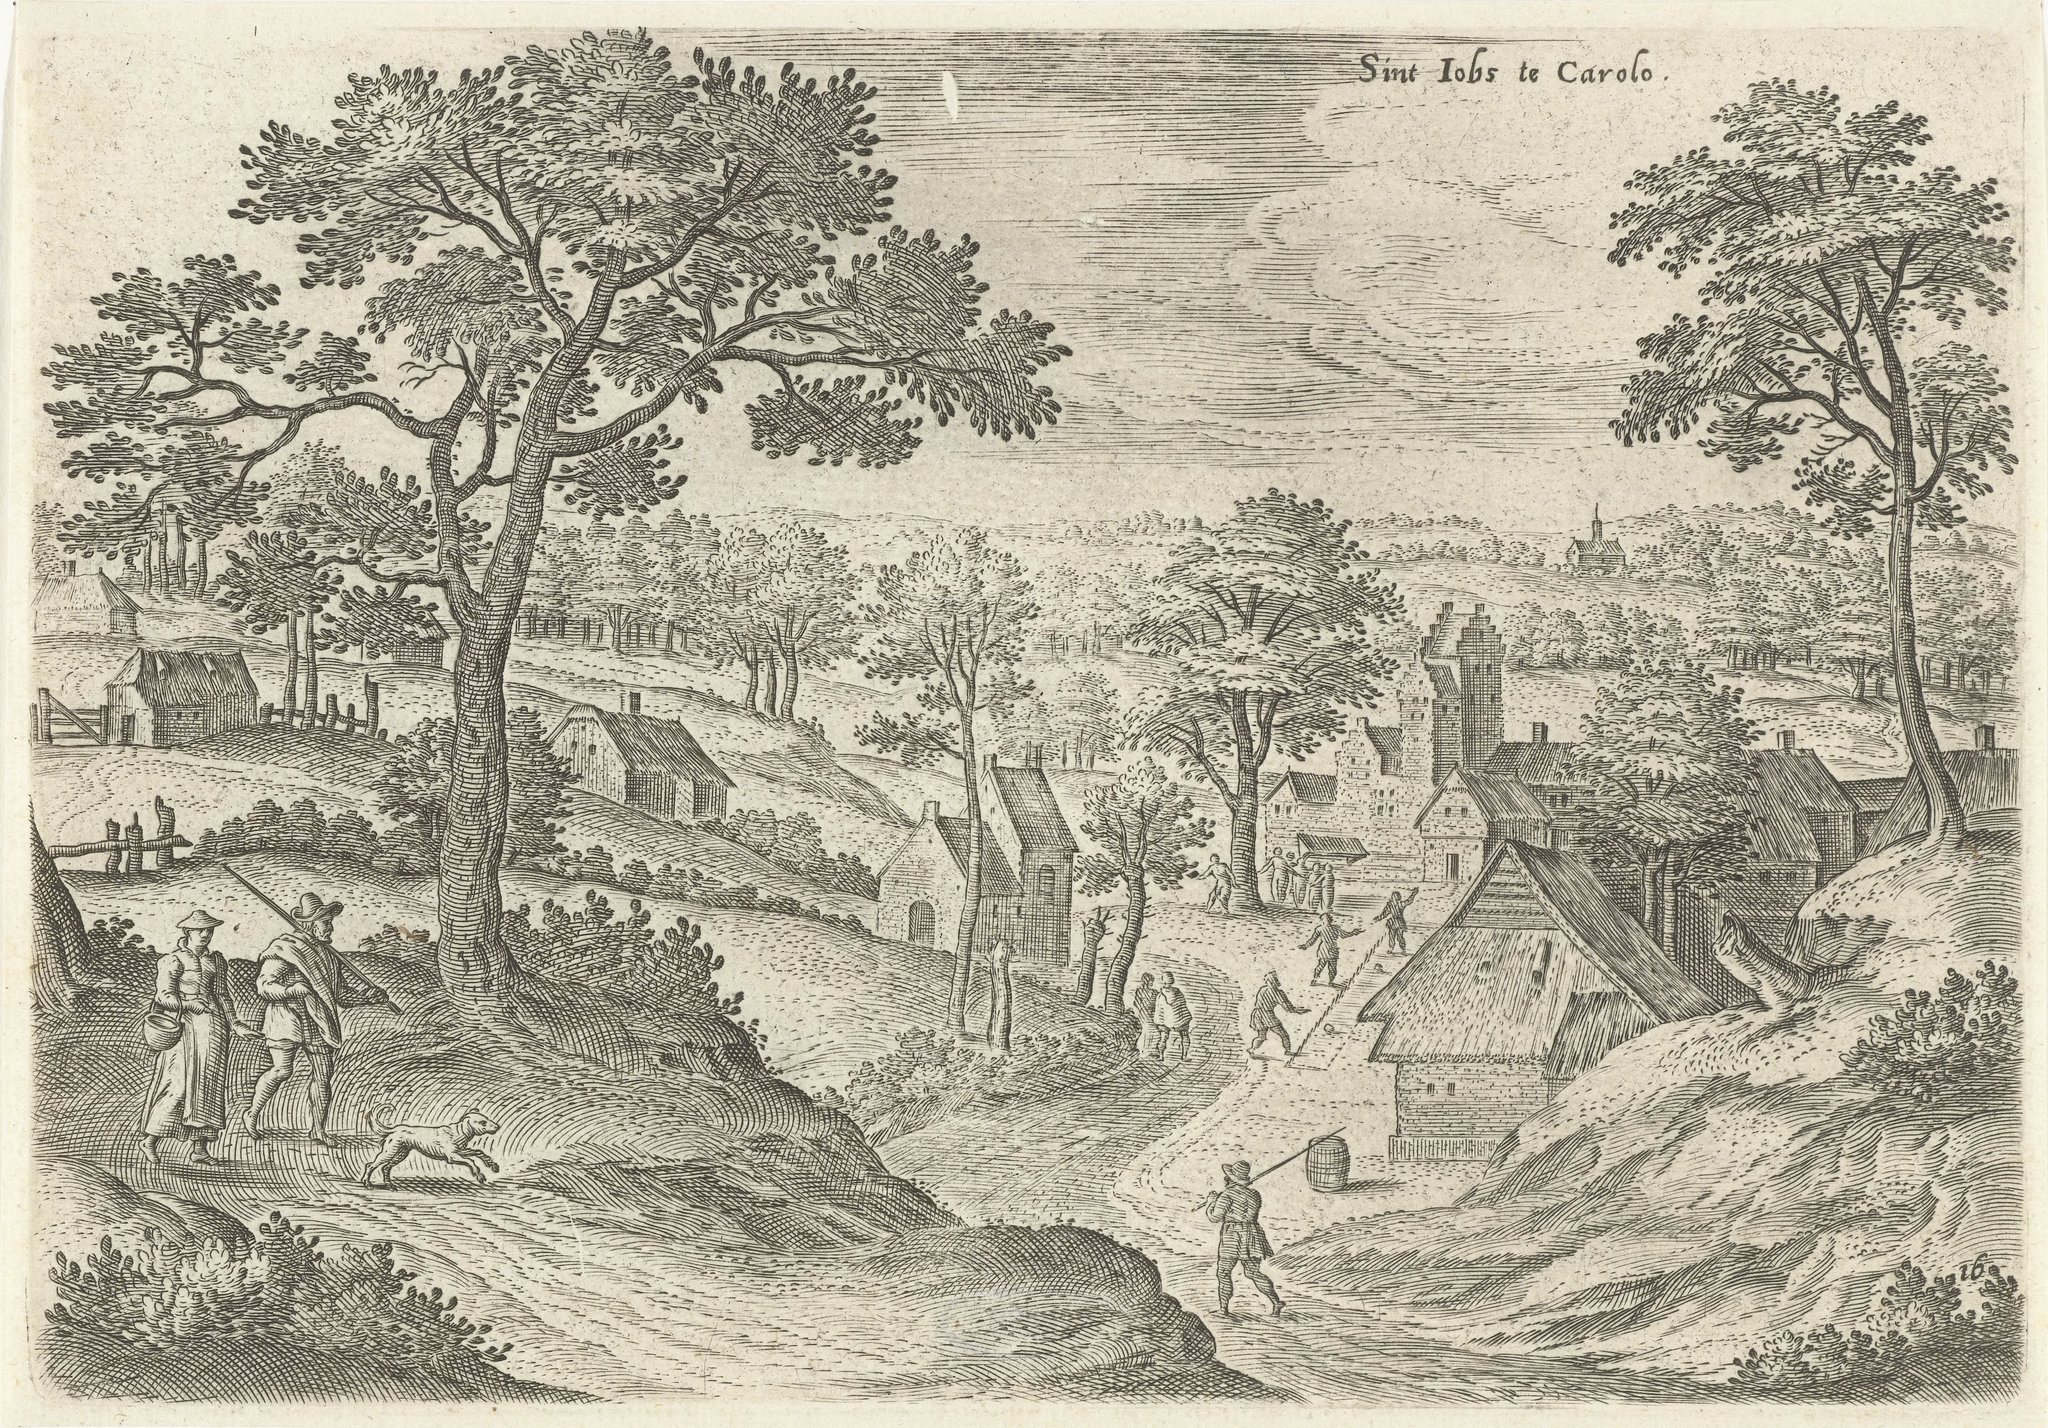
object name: print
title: Sint Iobs te Carolo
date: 1530-1580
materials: paper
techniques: engraving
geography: antwerp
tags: landscape with tower or castle (+ city(-scape) with figures, staffage)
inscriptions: collector's mark: Lugt 2228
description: Gezicht op de kasteelhoeve het hof van Carloo in de heerlijkheid Ukkel, vlakbij Brussel. De prent is deel van een serie met gezichten uit de omgeving van Brussel.